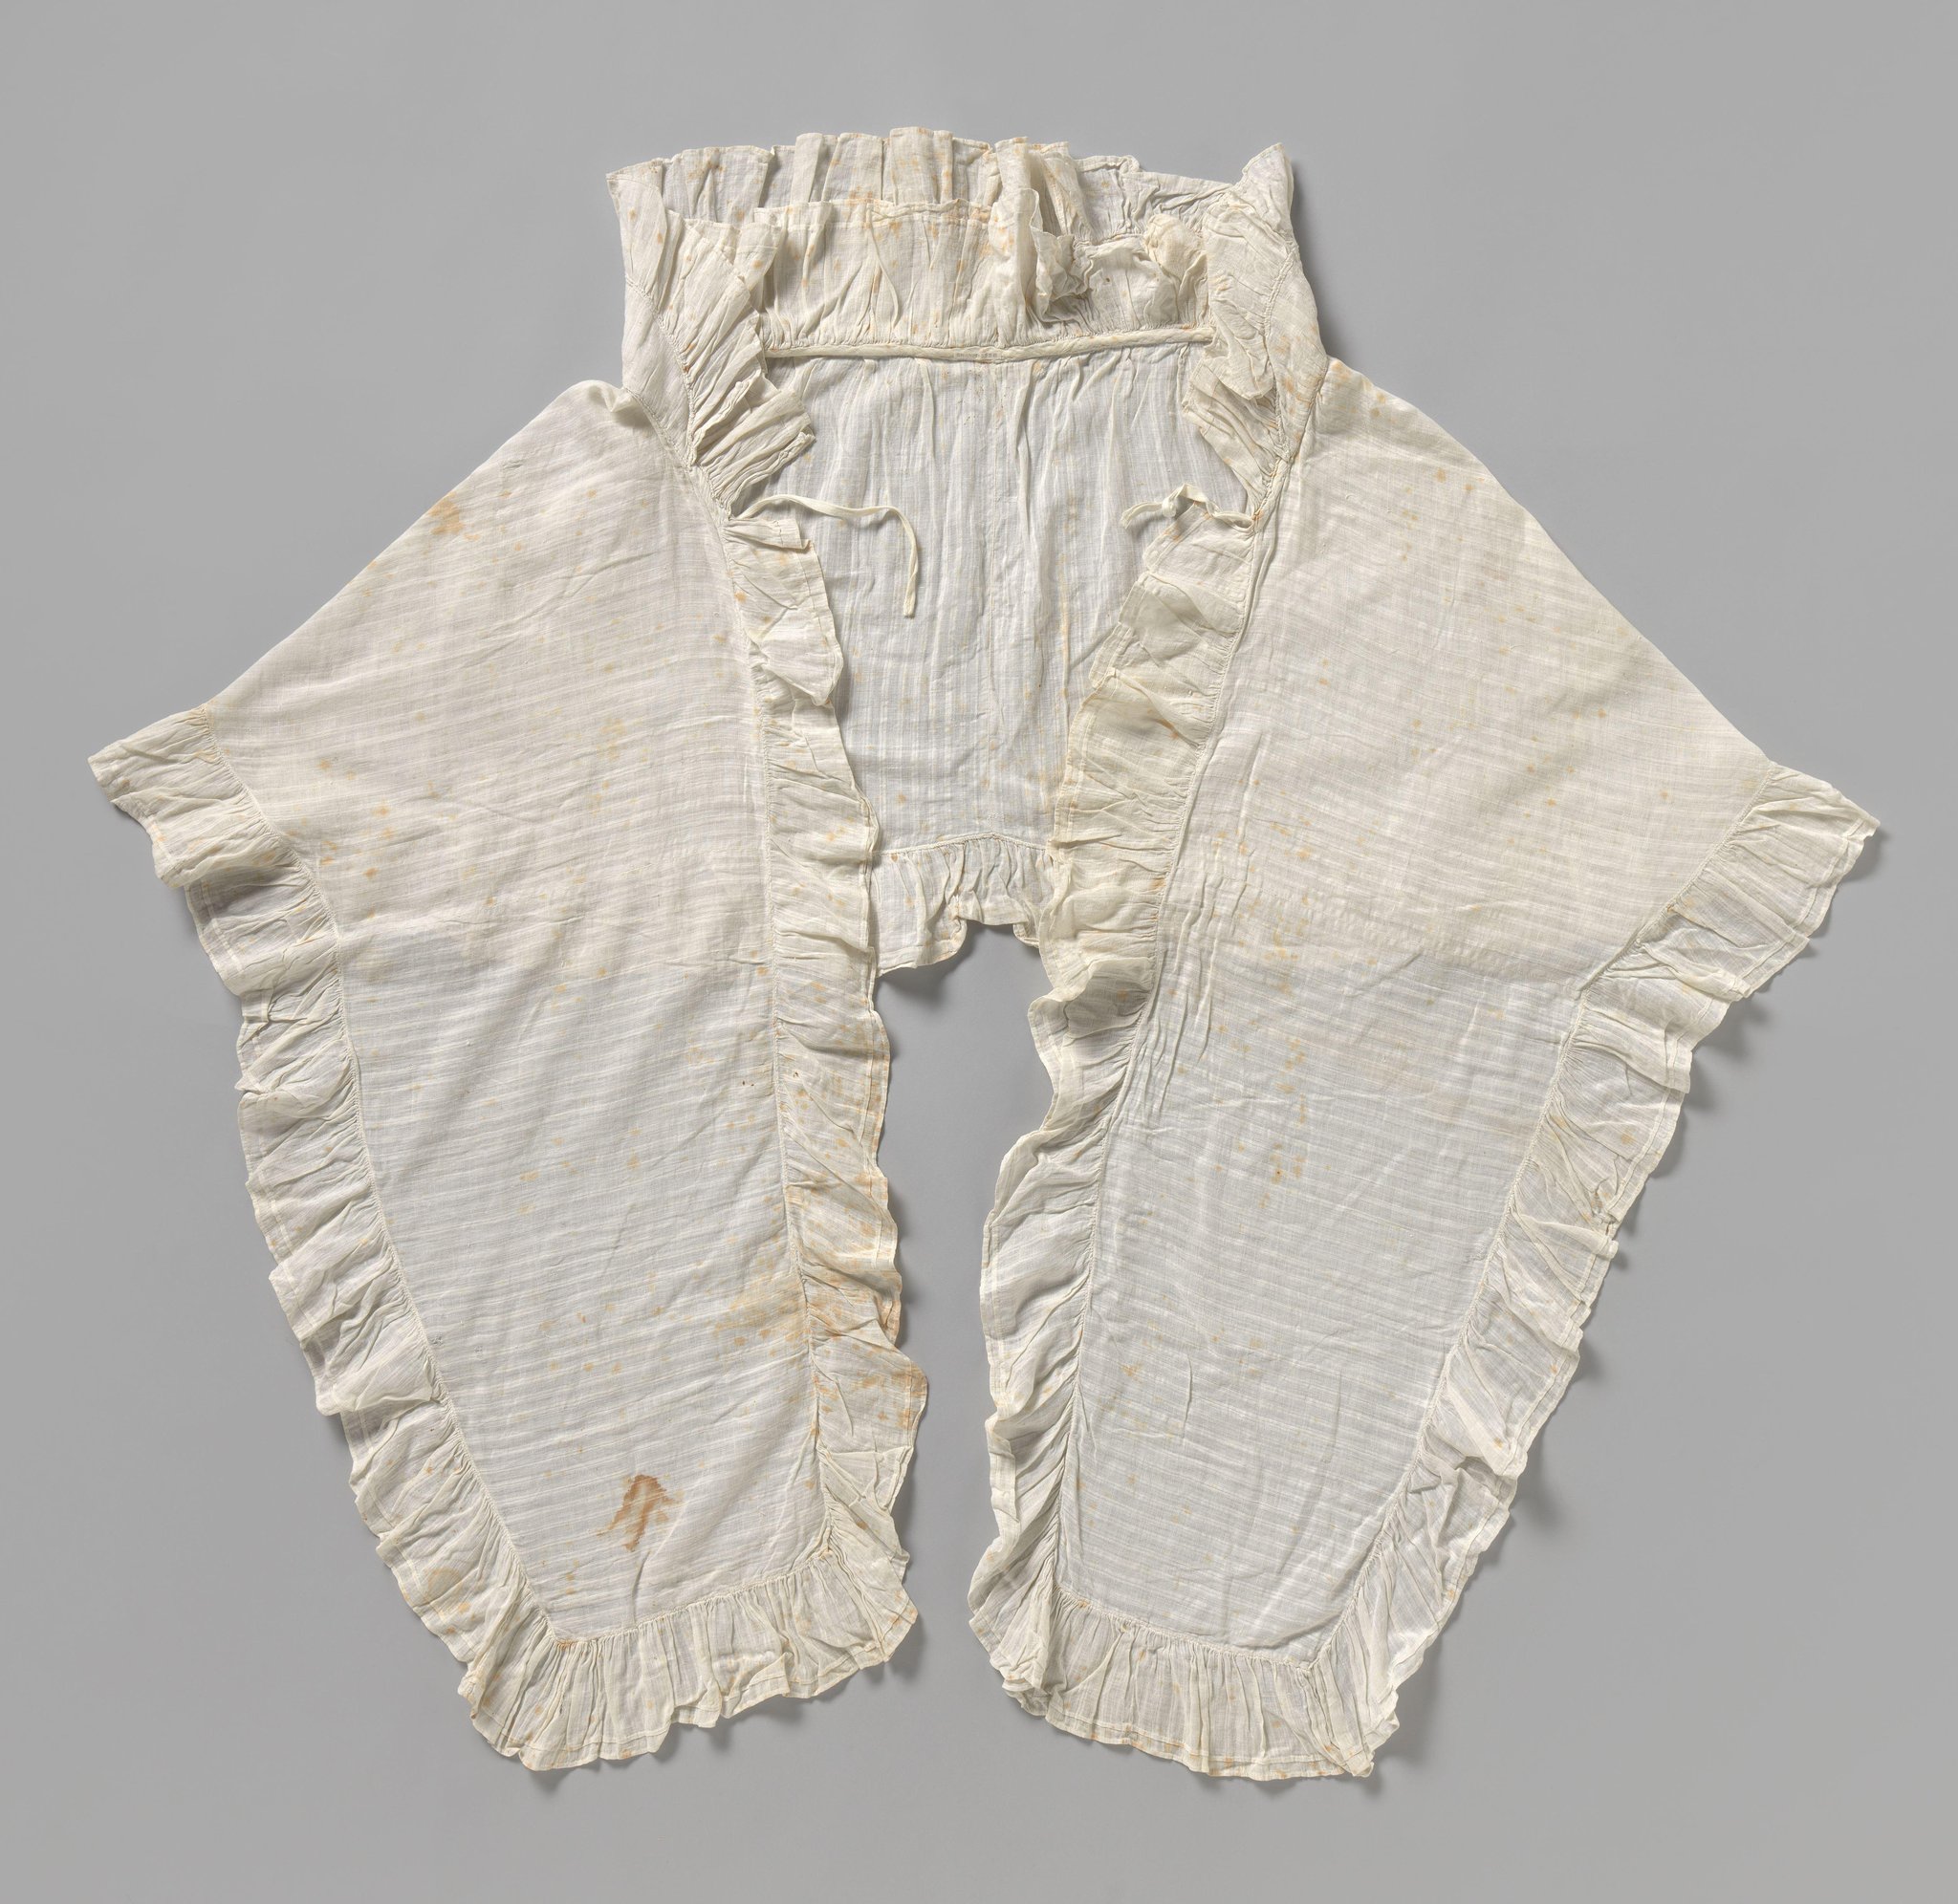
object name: clothing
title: Langwerpige omslagdoek van ecrukleurig neteldoek met ingeweven streep, omrand met een ruche langs de onderste rand, dubbele ruche langs de hals zijde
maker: Anonymous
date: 1820-1830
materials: cotton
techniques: weave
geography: netherlands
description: Langwerpige omslagdoek van ecrukleurig neteldoek met verticale ingeweven streep, omrand met een ruche met zeer fijne plooi langs de onderste rand, dubbele ruche langs de hals zijde. Middendeel is vervaardigd uit vier aan elkaar genaaide delen.